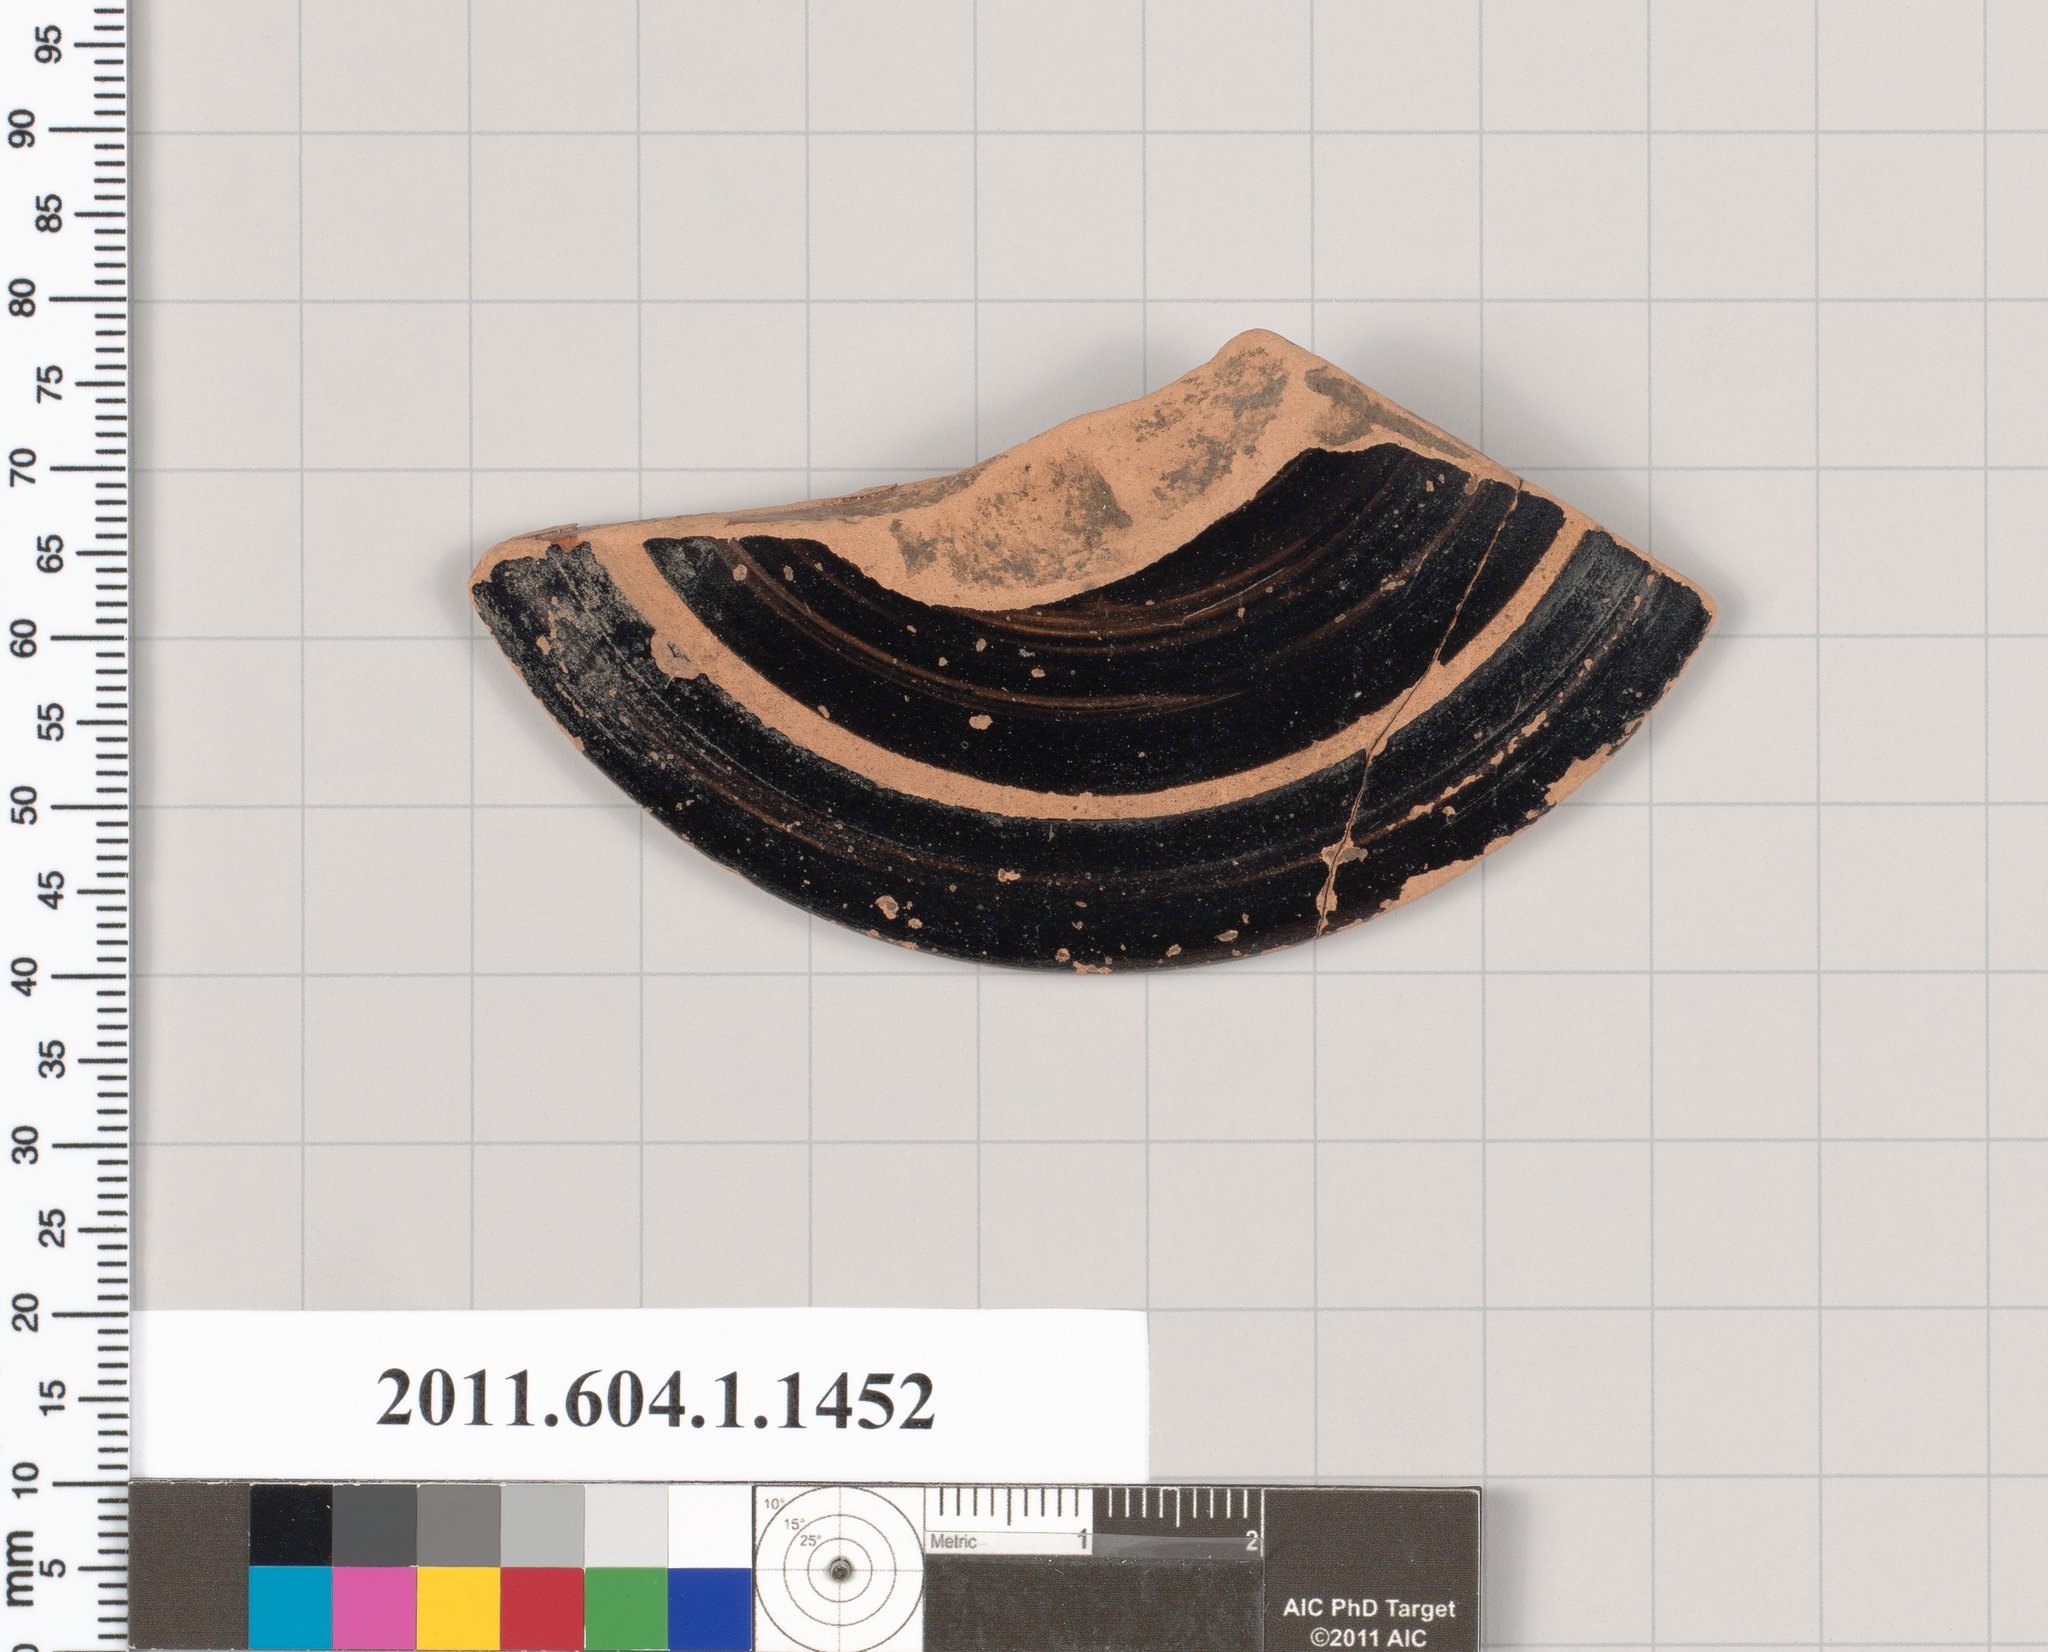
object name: kylix fragment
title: Terracotta fragment of a kylix (drinking cup)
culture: greek, attic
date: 500-401 BCE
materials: terracotta